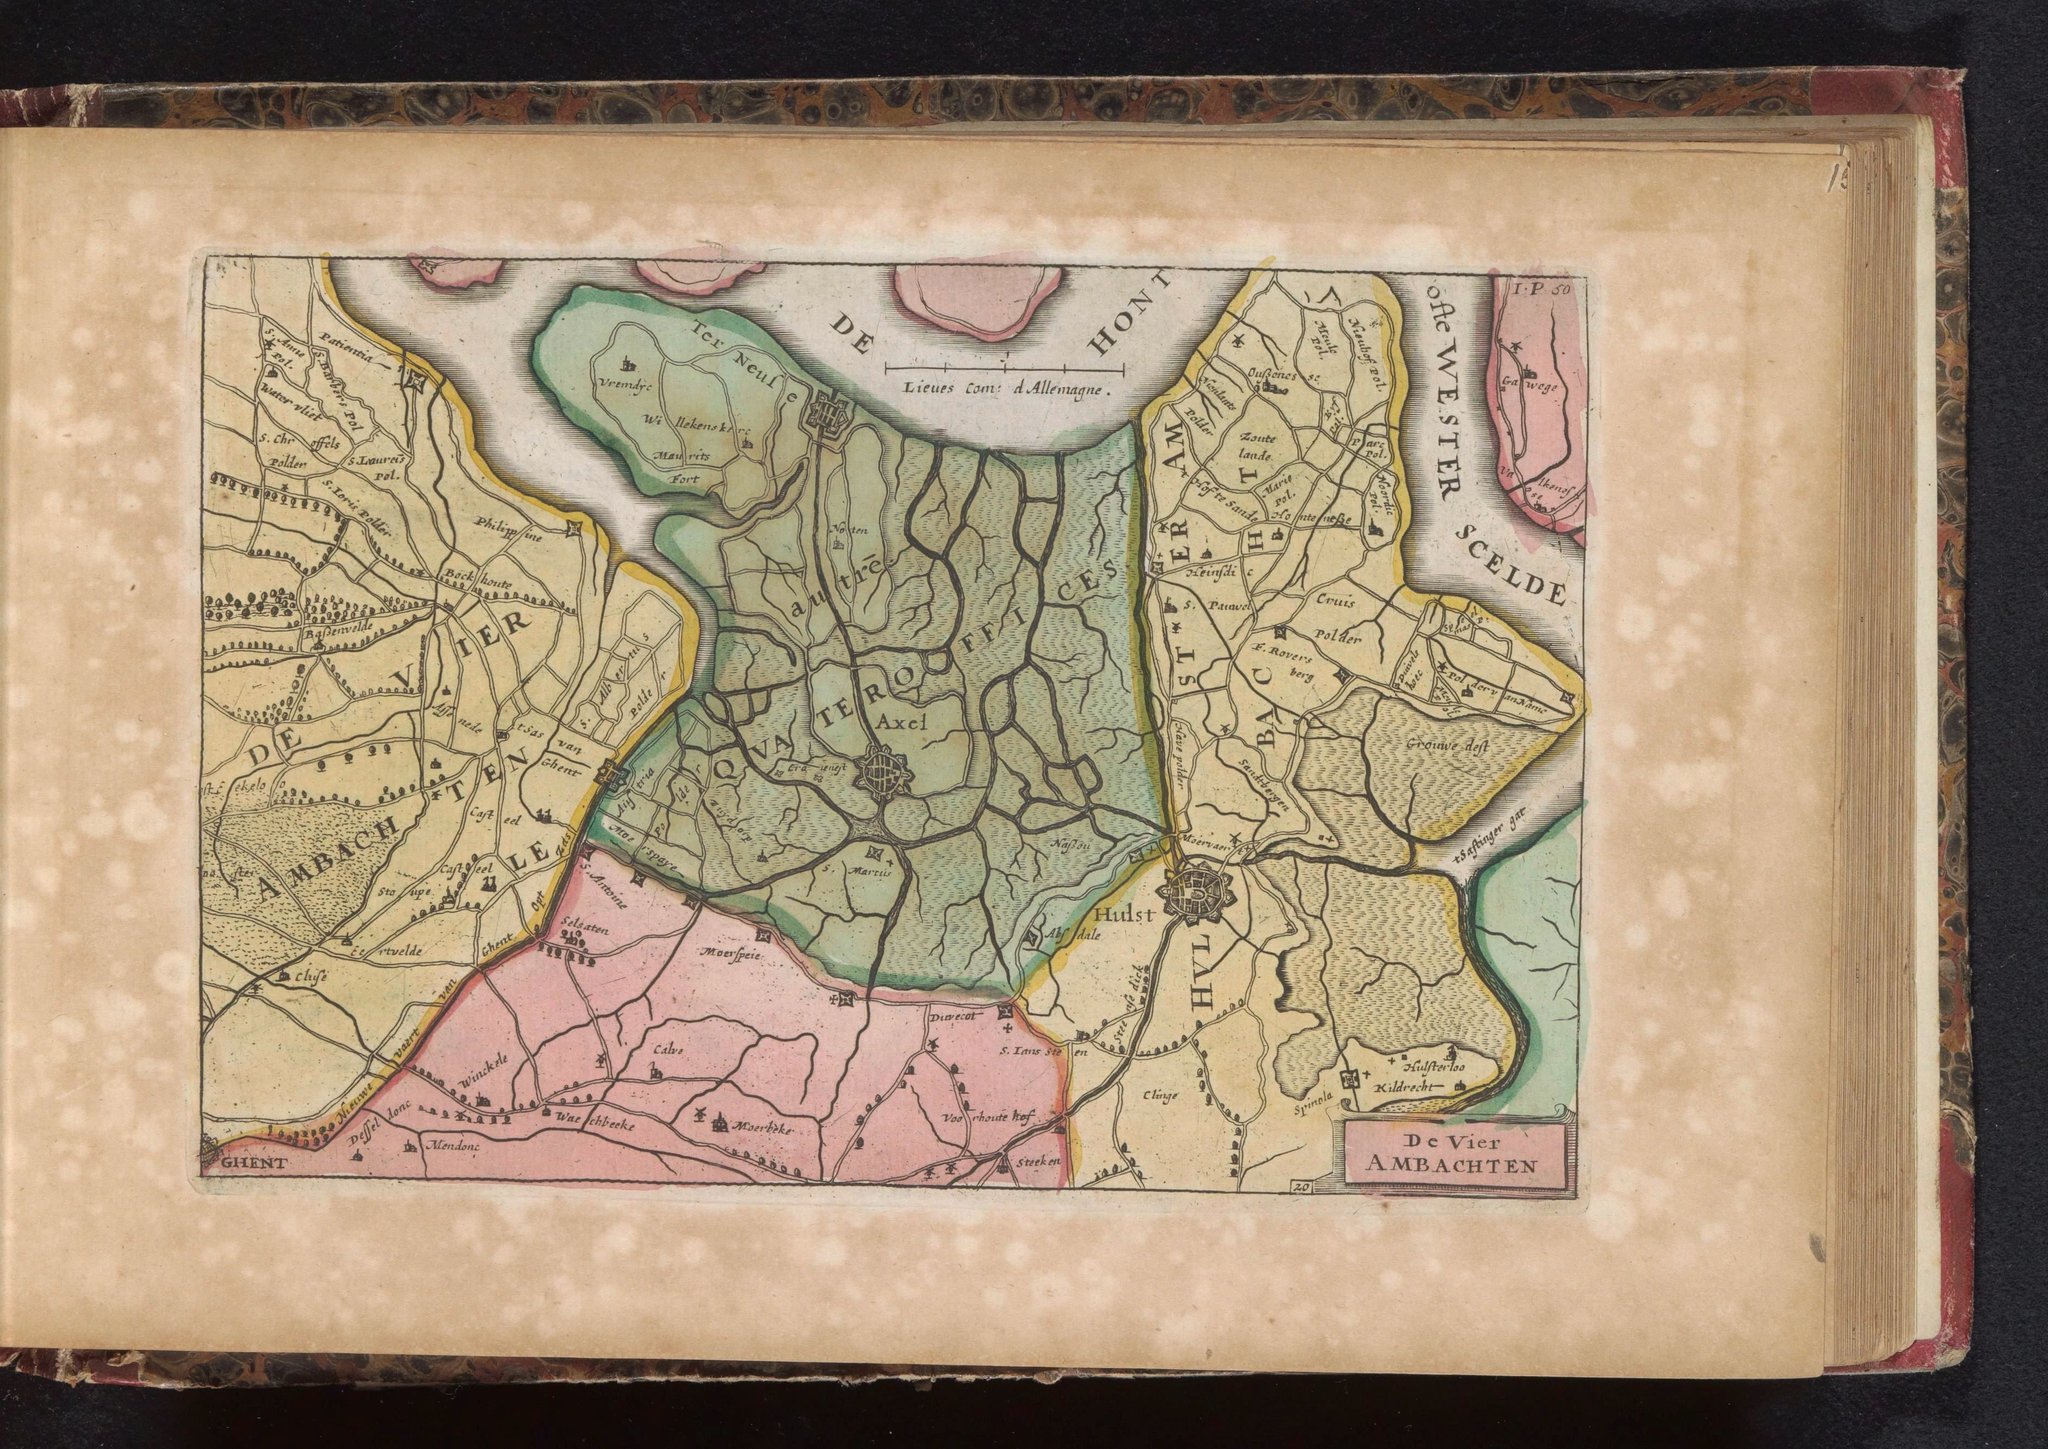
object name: map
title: Kaart van de Vier Ambachten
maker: Anonymous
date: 1700-1702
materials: paper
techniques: engraving, hand coloring, lacquer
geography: amsterdam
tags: maps of separate countries or regions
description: Kaart de Vier Ambachten, een bestuurlijke en juridische eenheid in het graafschap Vlaanderen. Deel van het huidige Zeeuws-Vlaanderen met de steden Terneuzen, Axel en Hulst. Onderdeel van een atlas met 223 kaarten van landen en steden en oorlogstaferelen in Europa in de periode ca. 1690-1735.